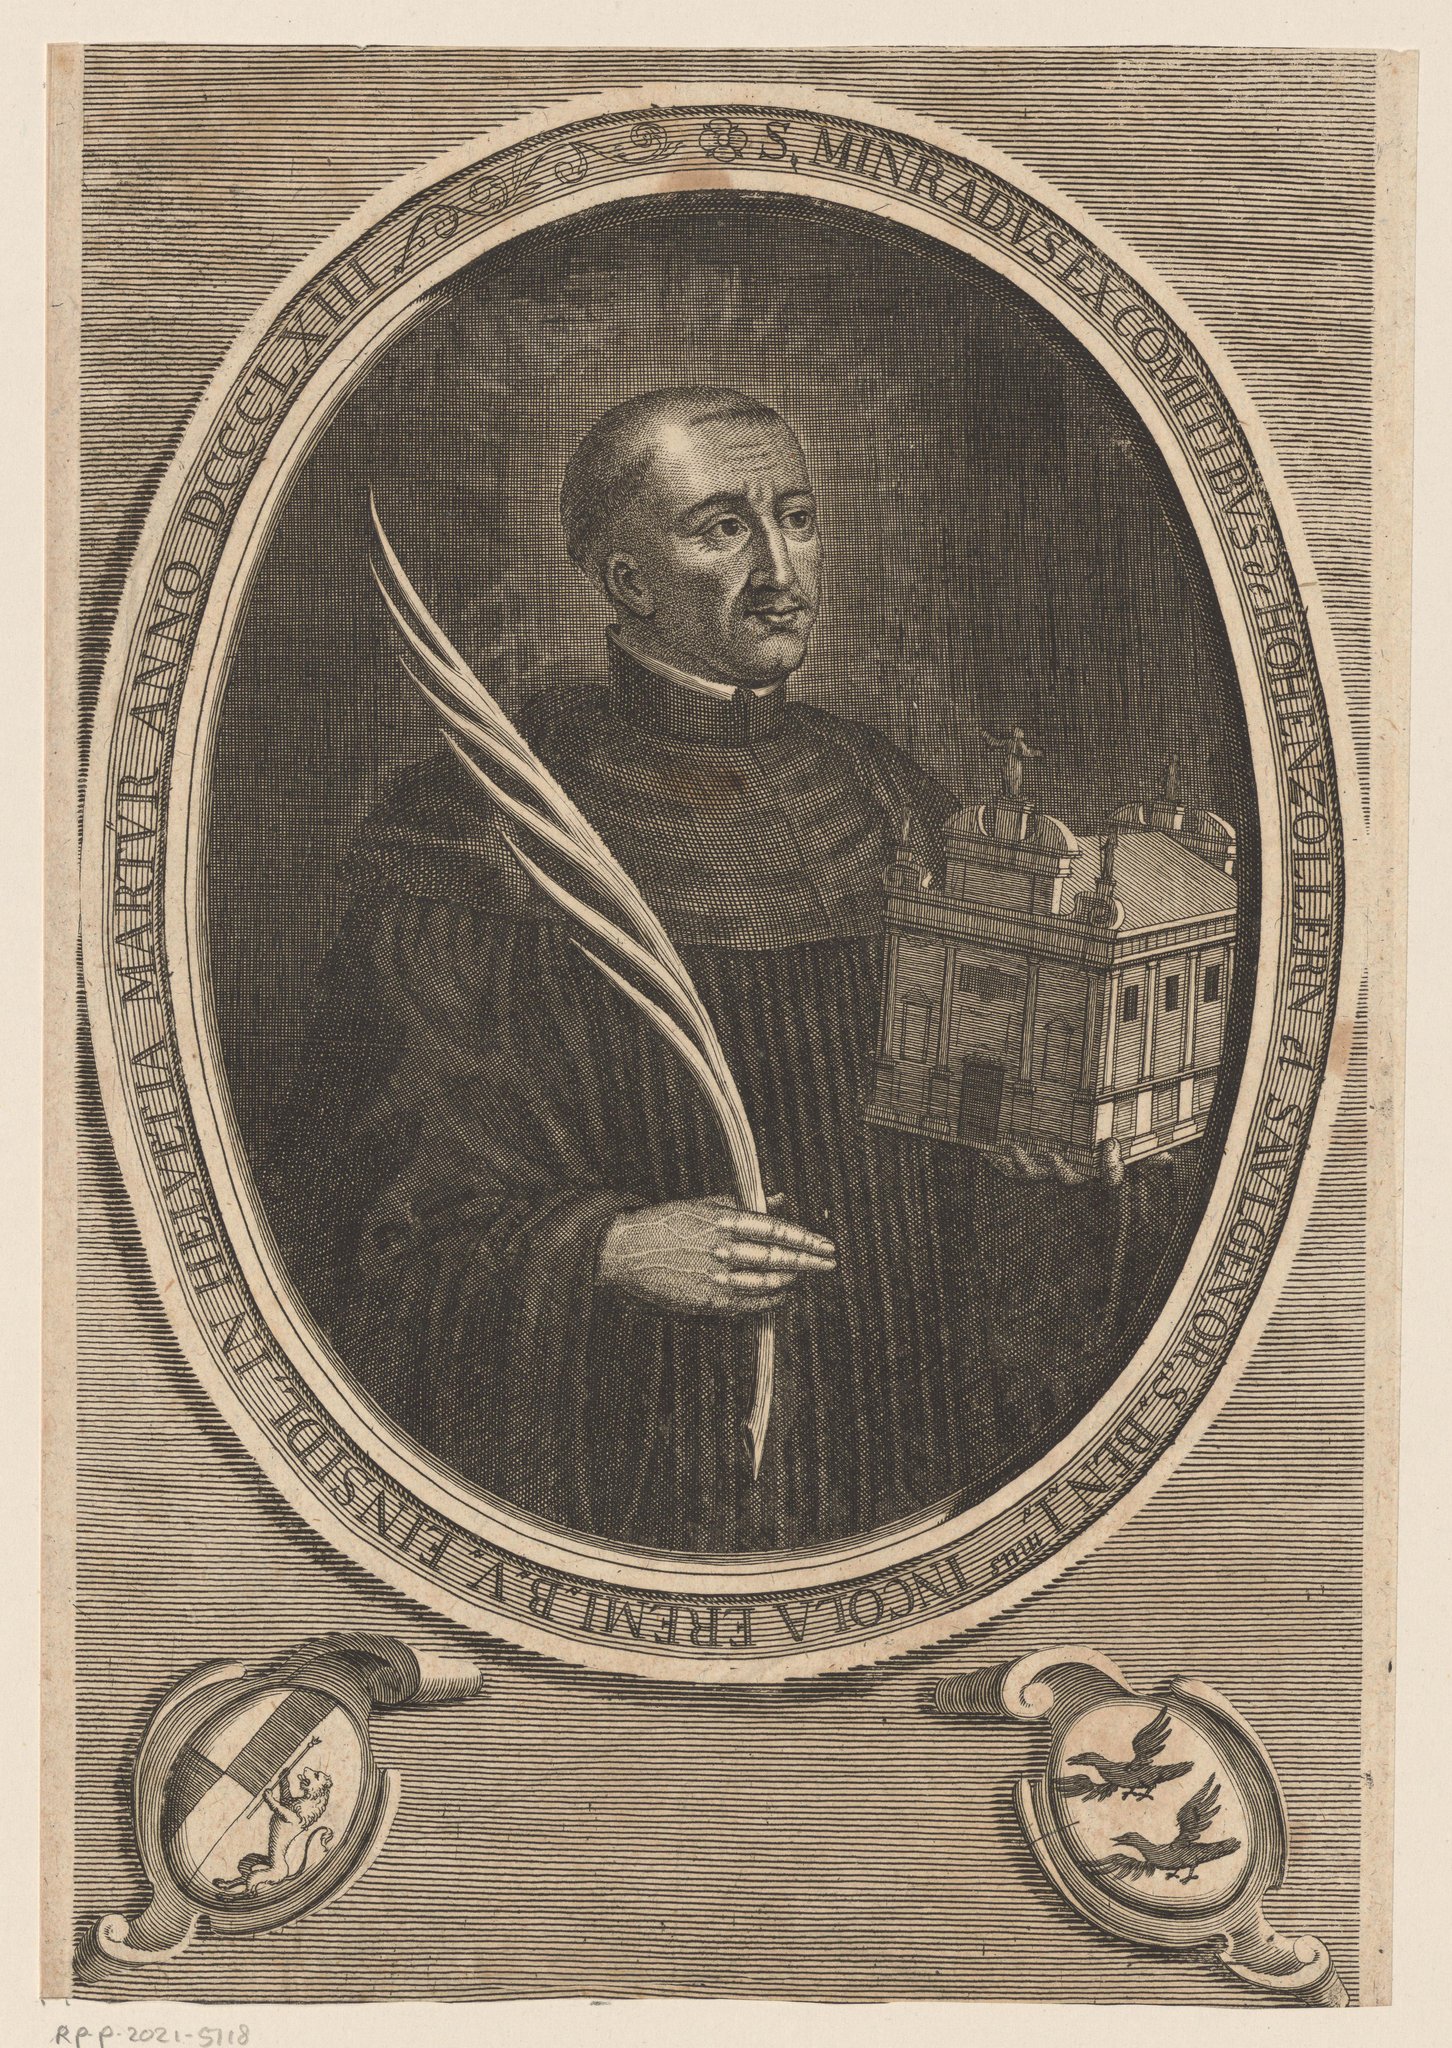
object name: print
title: Portret van Meinrad, graaf van Hohenzollern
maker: Anonymous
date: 1703-1714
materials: paper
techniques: engraving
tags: adult man, historical persons, martyr(s) (often with palm-branches), armorial bearing, heraldry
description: Prent uit: Pregitzer, Johann Ulrich. Dess Heiligen Römischen Reichs Teutscher Nation, und dessen Stände, Regierungs- Und Ehren-Spiegel (...). Frankfurt en Leipzig: Friederich Roth-Scholtz, 1714. Of uit: Pregitzer, Johann Ulrich. Teutscher Regierungs- und Ehren-Spiegel, Vorbildend Des Teutschen Reichs, und desselben Stände, ersten Anfang, Fortleitung, Hoheit, Macht, Recht, und Freyheit (...). Berlijn: Rüdiger, 1703.